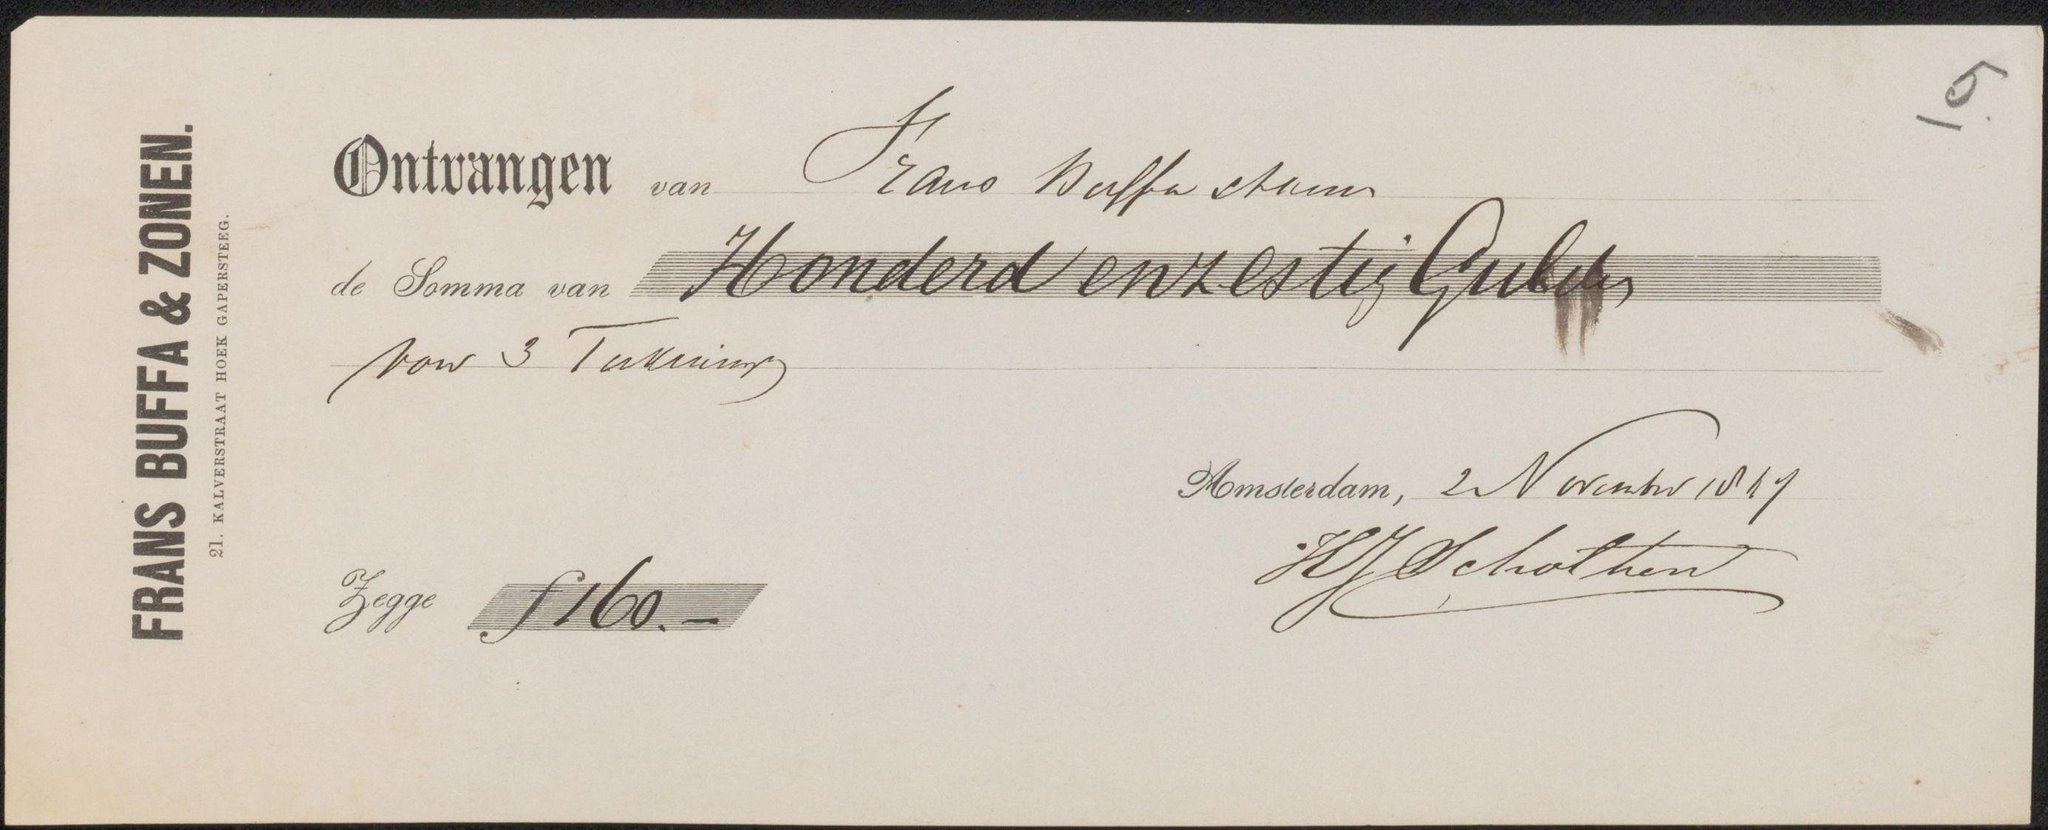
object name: ontvangstbewijs, kwitantie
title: Kwitantie voor Hendrik Jacobus Scholten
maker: hendrik jacobus scholten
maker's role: draughtsman, painter, print maker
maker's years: 1824-1907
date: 1867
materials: ink, paper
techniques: pen, printing, writing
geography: amsterdam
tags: drawing, money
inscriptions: collector's mark: Lugt 2233